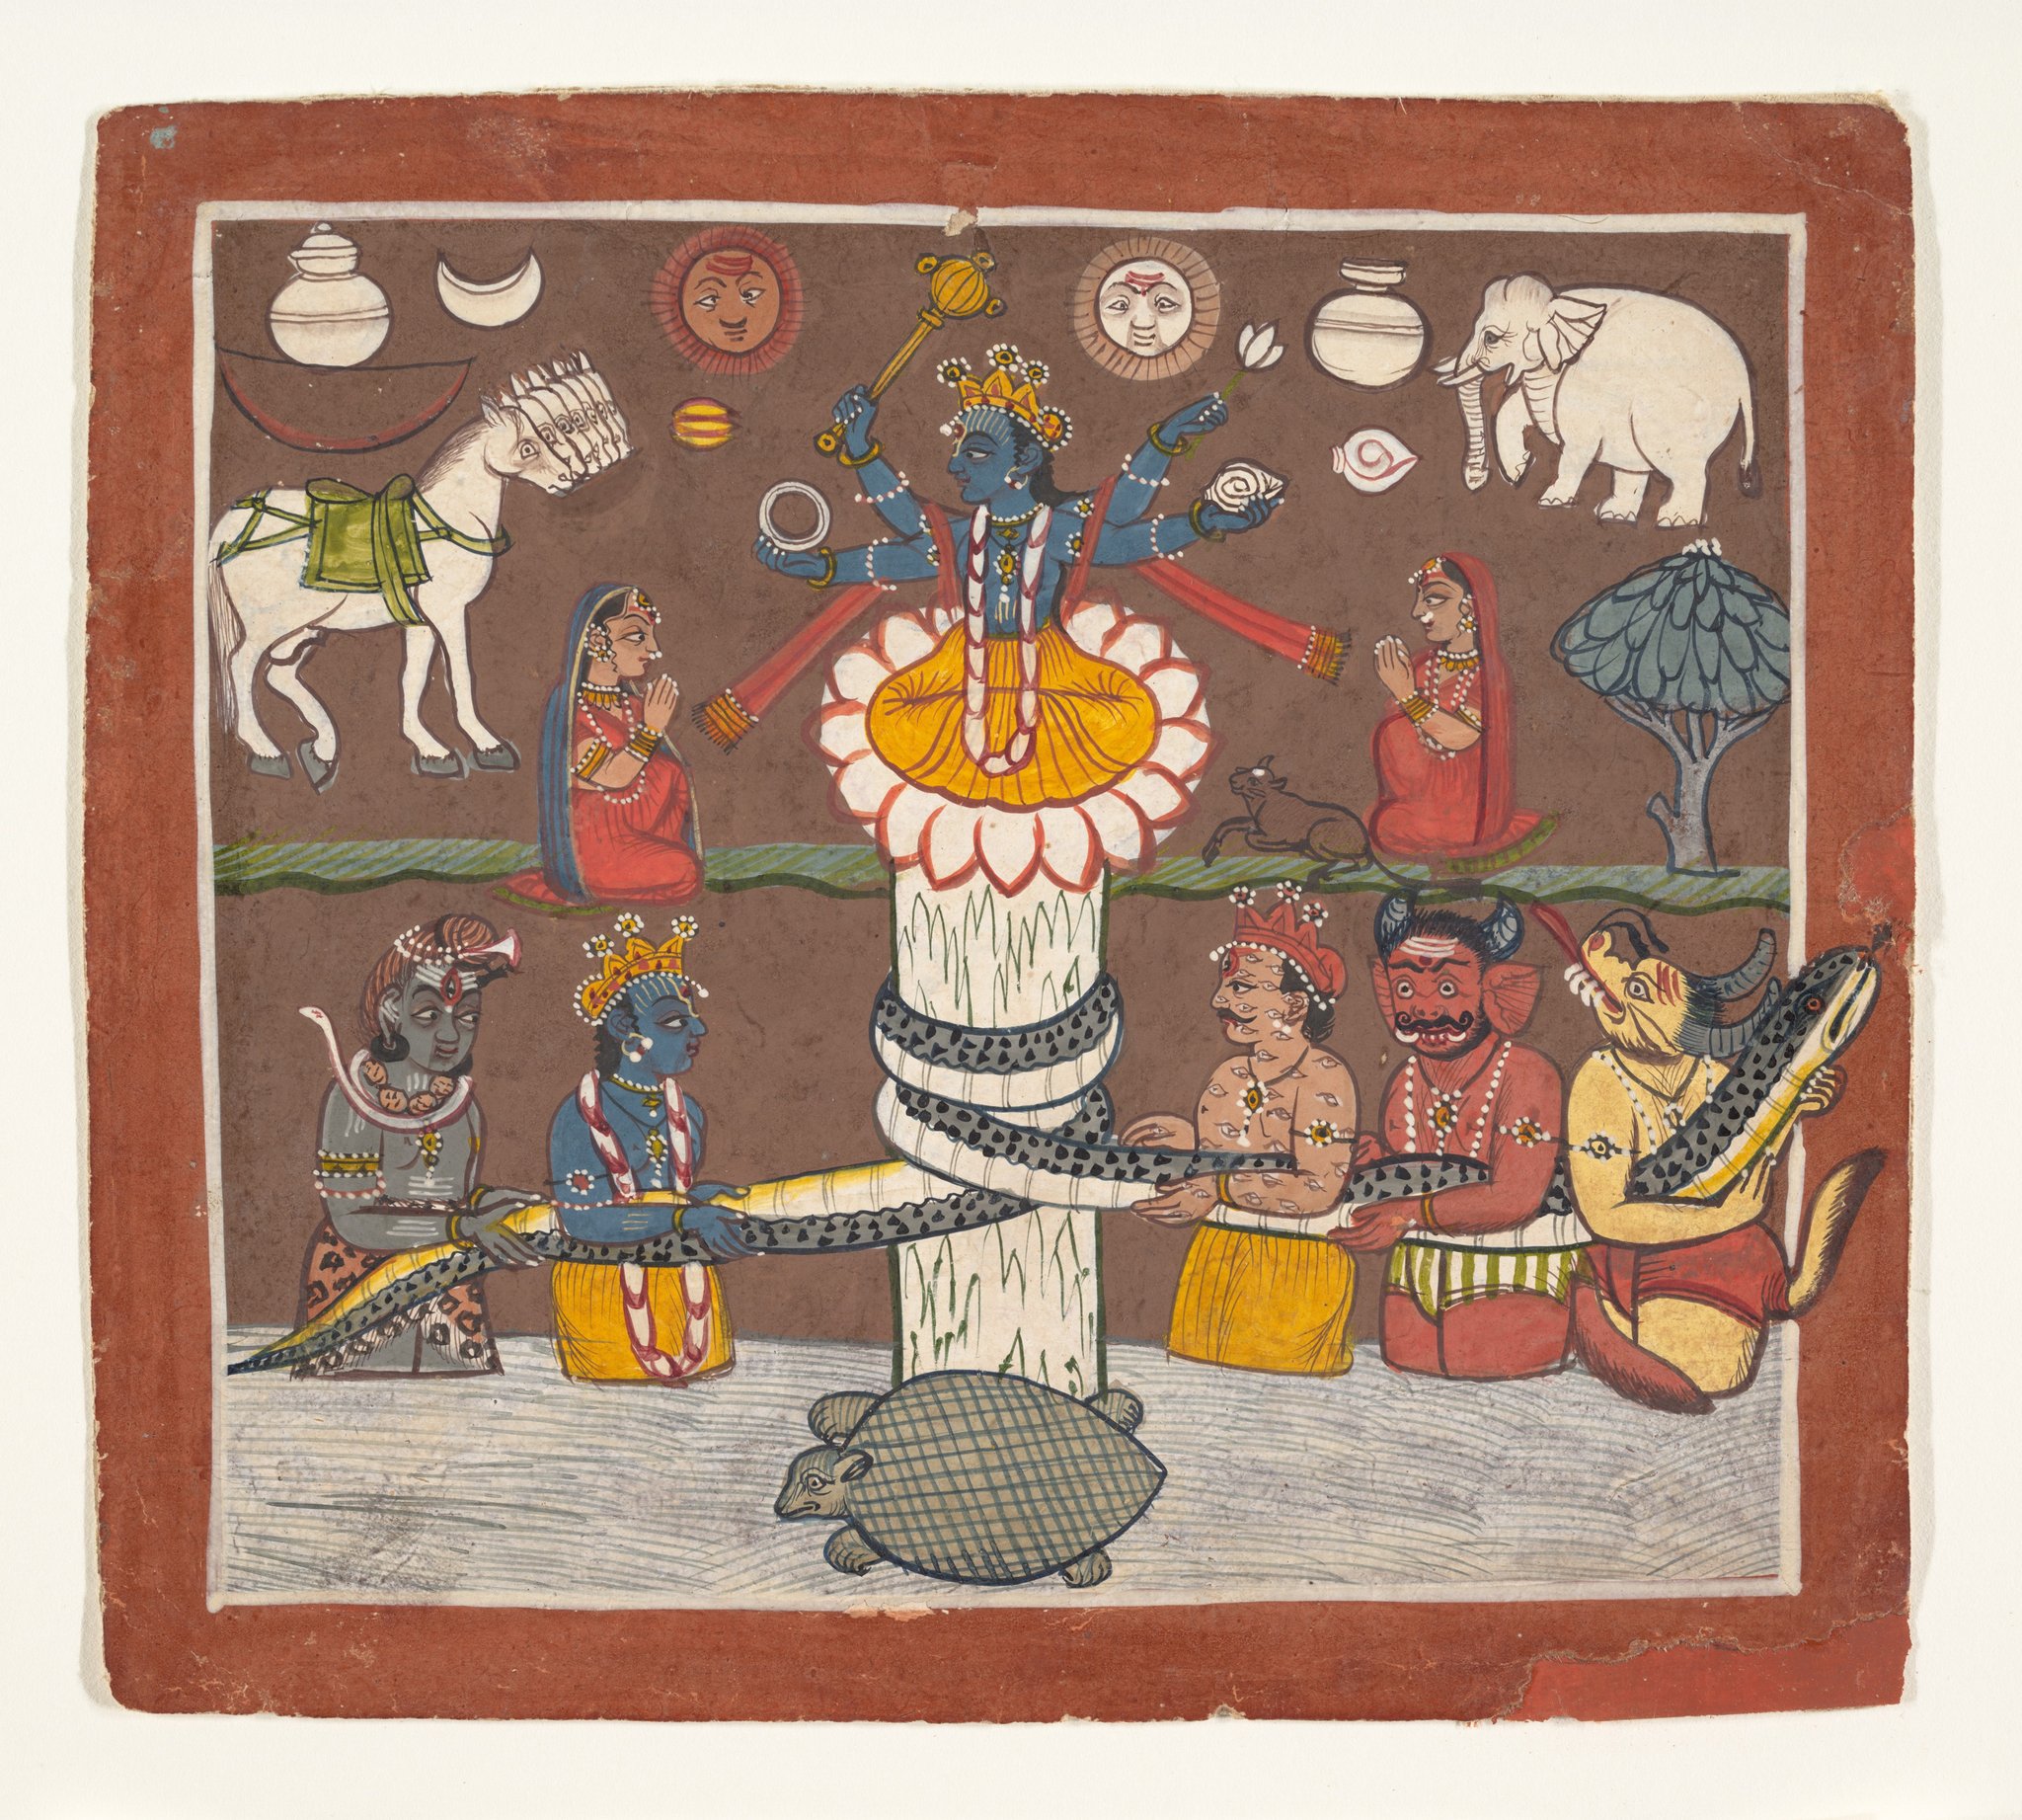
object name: painting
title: The Churning of the Ocean of Milk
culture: indian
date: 1780-1790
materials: ink, paper, watercolor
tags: elephants,snakes,turtles,demons,vishnu